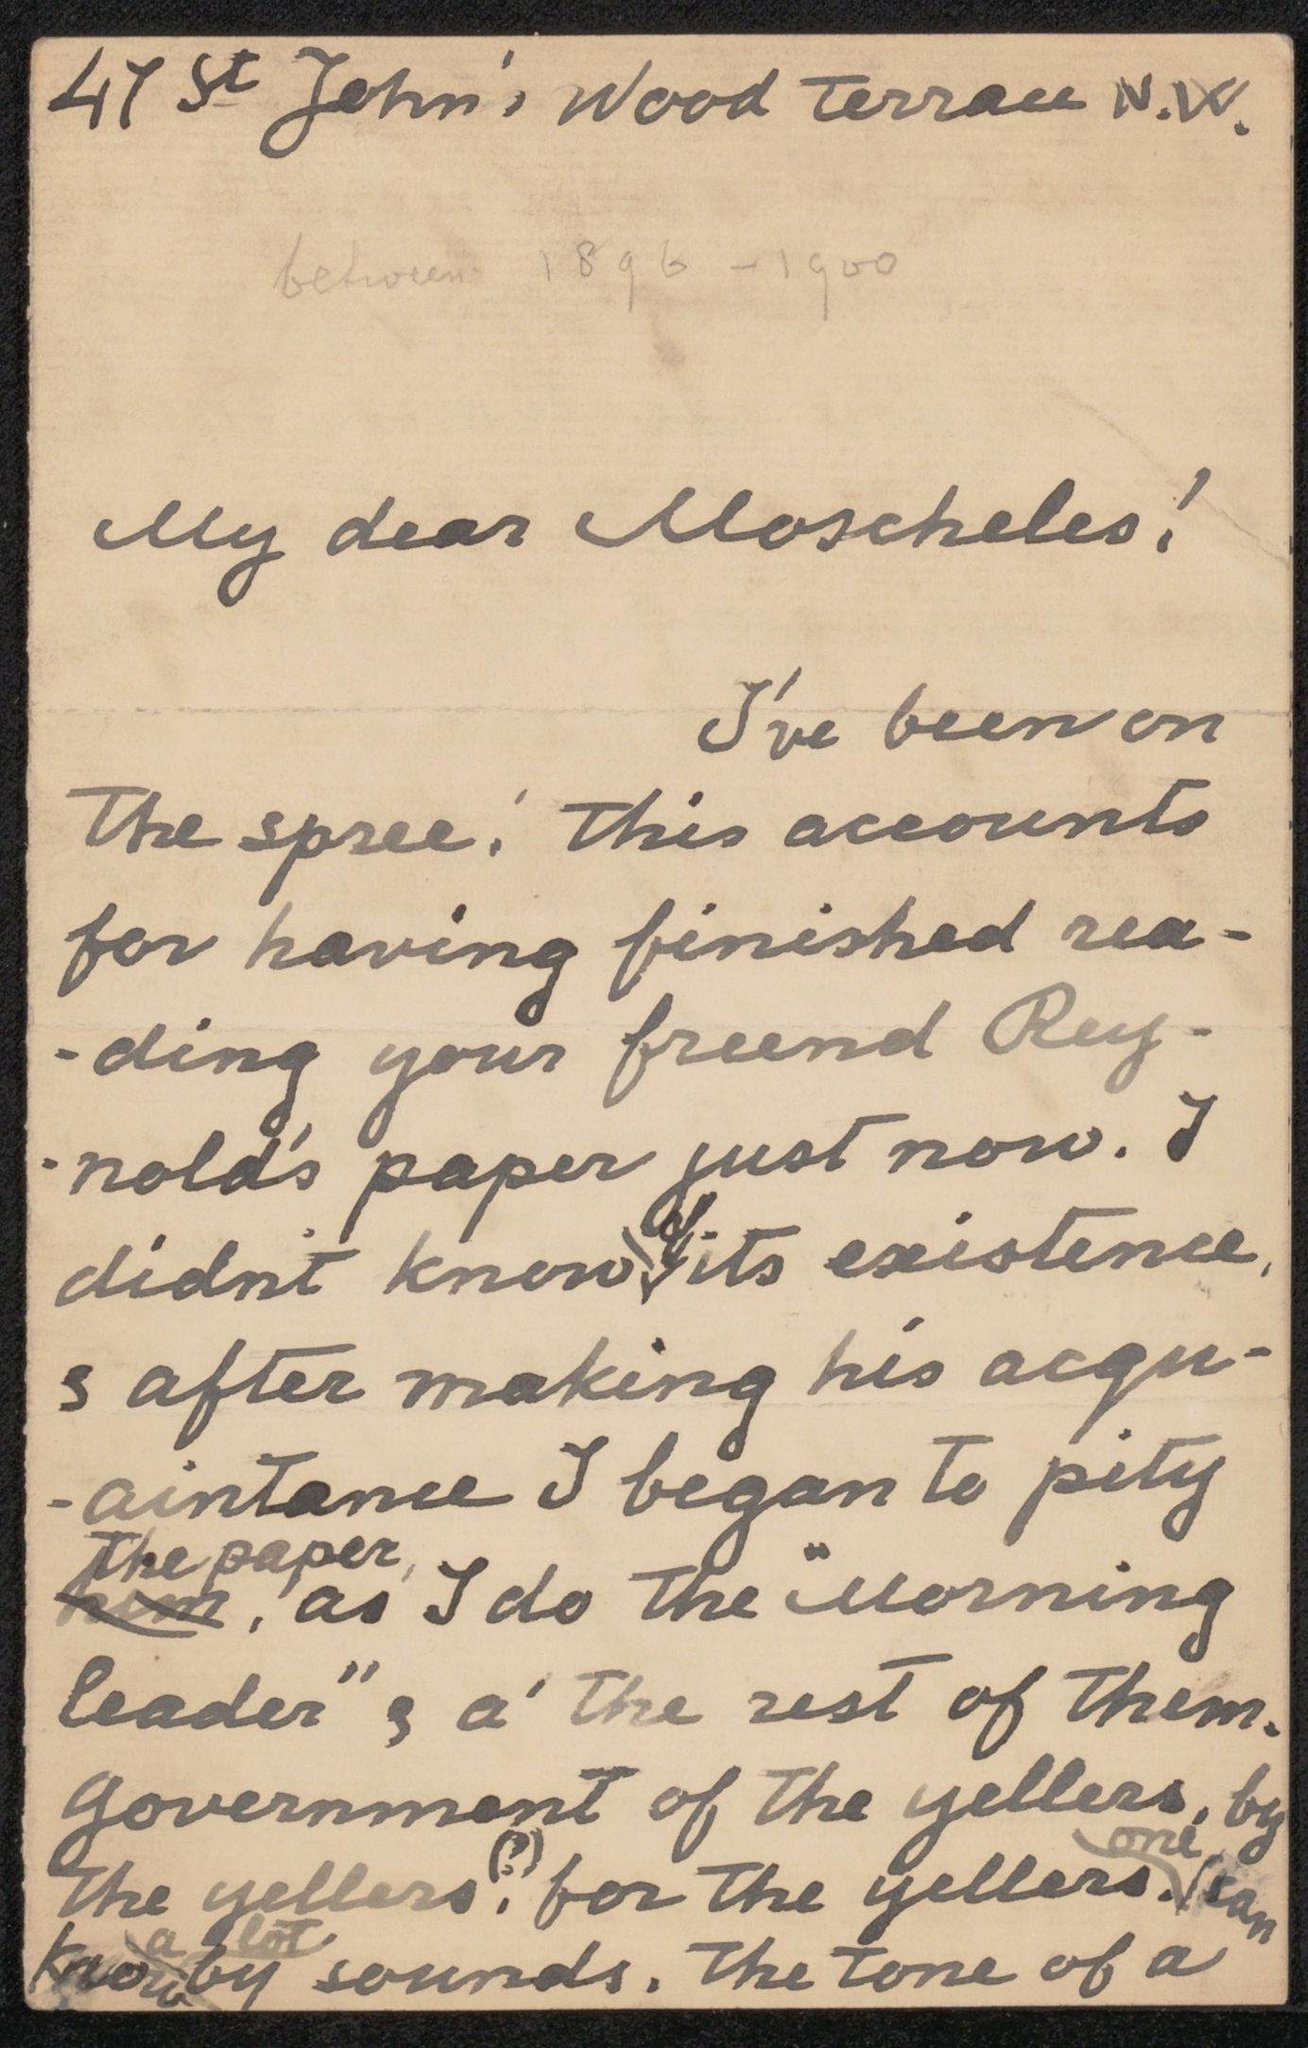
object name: letter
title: Brief aan Felix Stone Moscheles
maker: matthijs maris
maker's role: draughtsman, painter, print maker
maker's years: 1839-1917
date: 1888-1906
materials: ink, paper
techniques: pen, writing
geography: london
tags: london, painter, paris, jules breton, literature ~ arts, christian religion, money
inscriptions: watermark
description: Brief gedateerd 1896-1900 in latere hand.